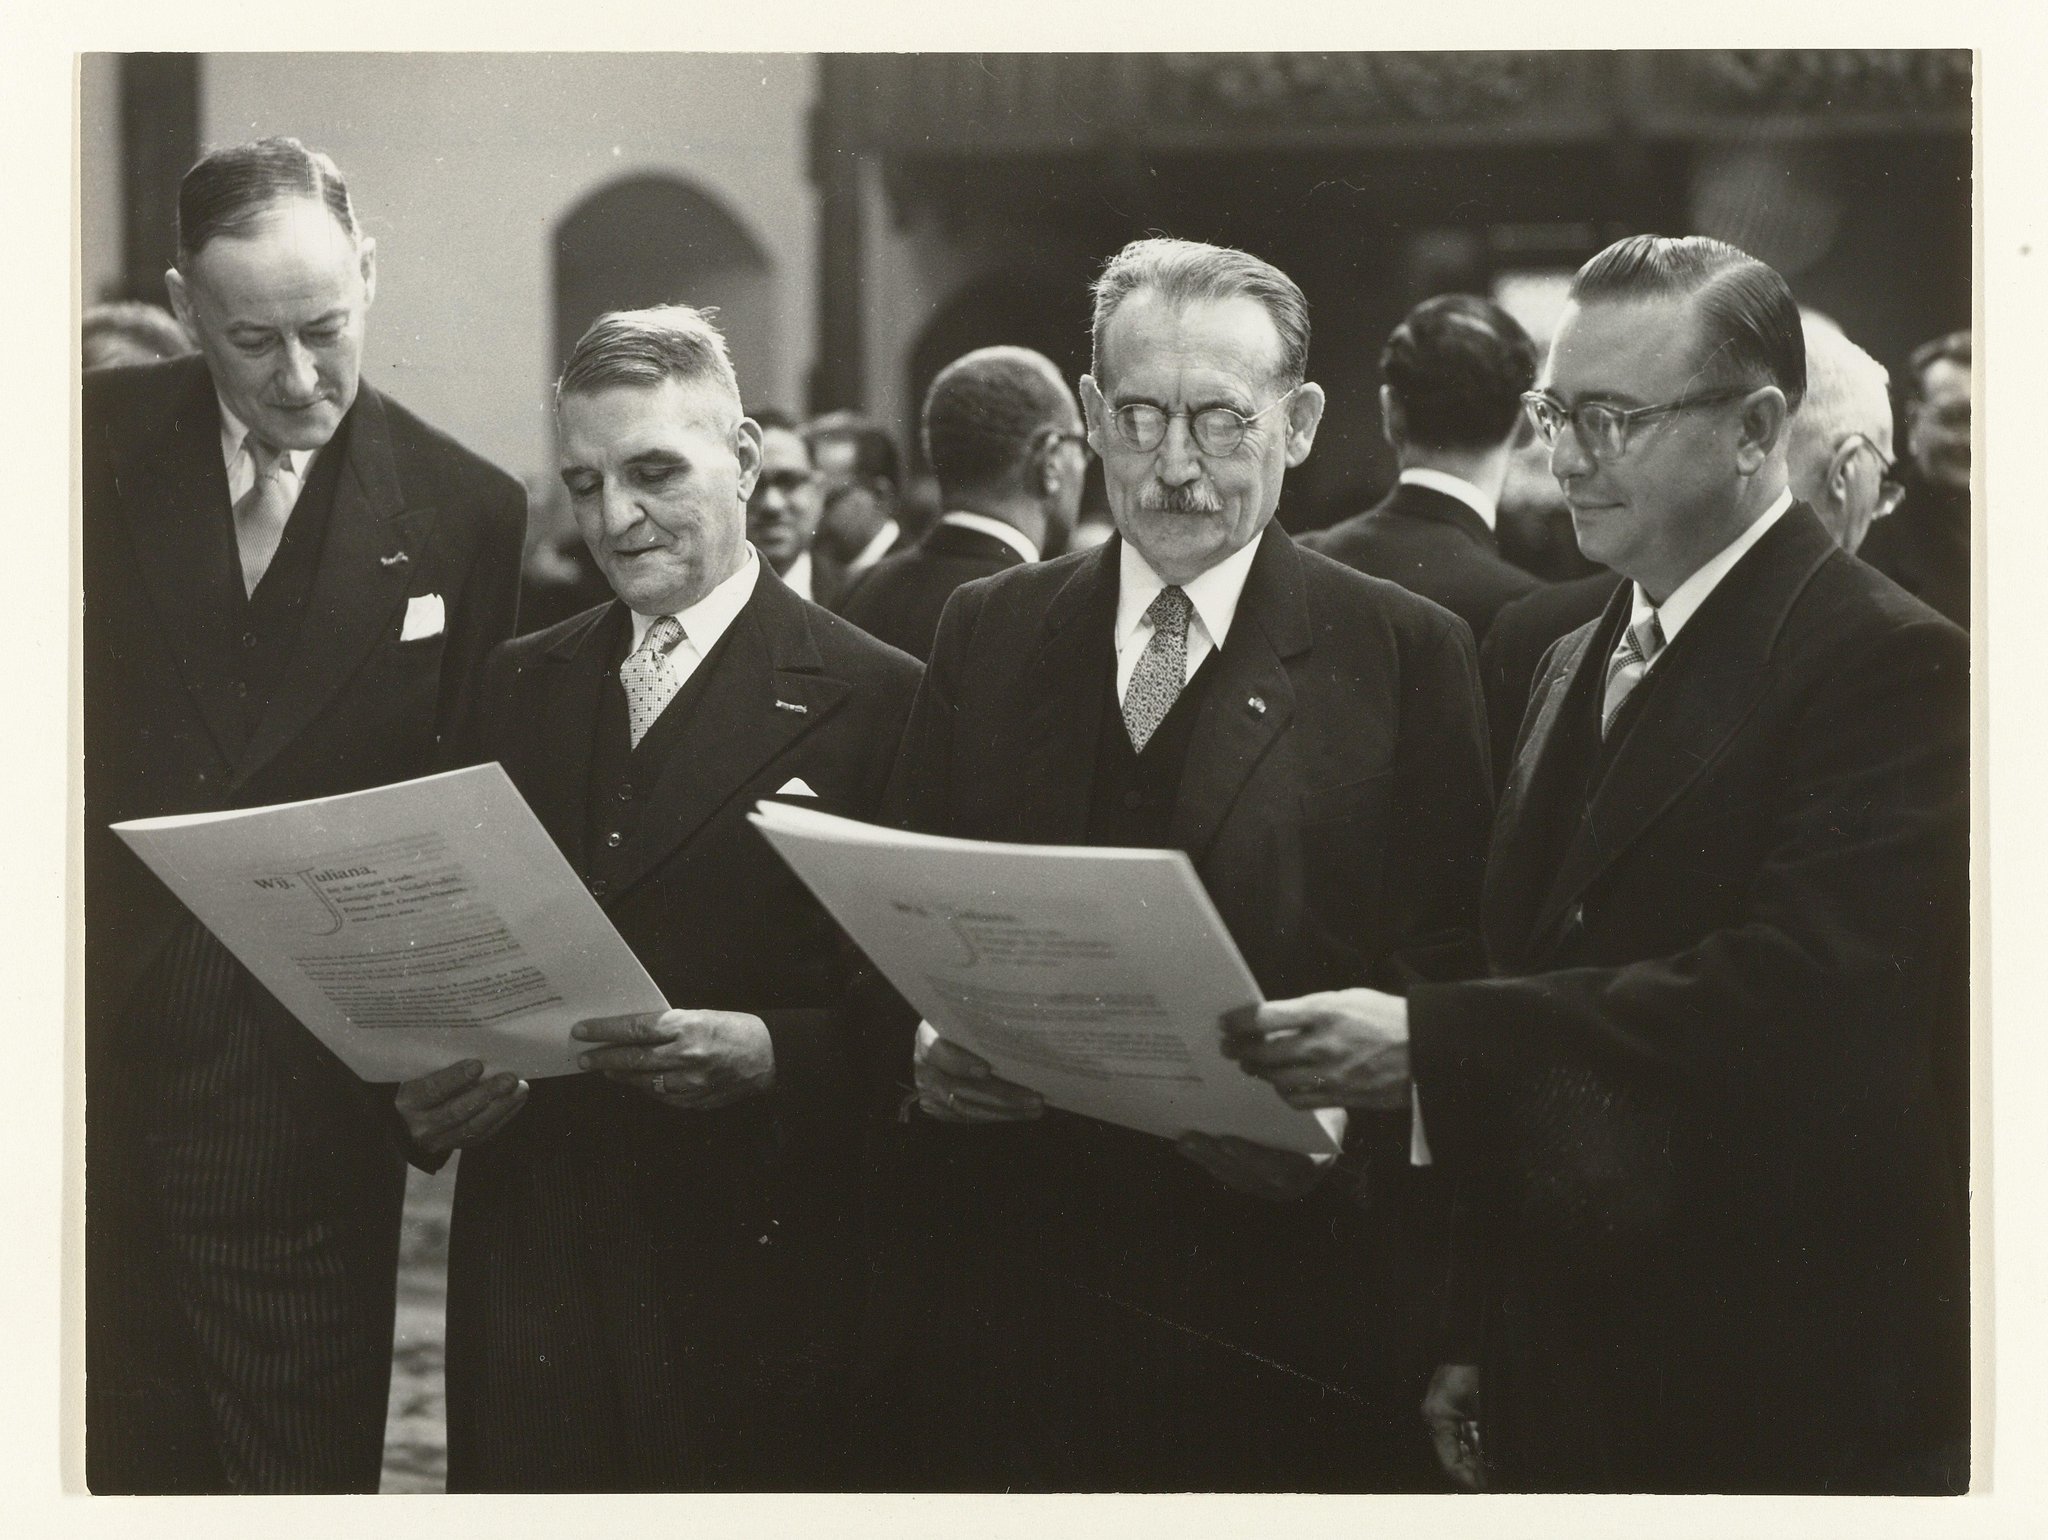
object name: photograph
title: Willem Drees en het Statuut met de West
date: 1954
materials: photographic support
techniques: photography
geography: the hague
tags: utrecht, willem drees, netherlands, suriname, the hague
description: Willem Drees bekijkt in de Ridderzaal het nieuwe Statuut voor het Koninkrijk der Nederlanden, 15 december 1954. Het Statuut regelde de nieuwe verhoudingen tussen Nederland, Suriname en de Nederlandse Antillen. Links van Drees staan de heren Kernkamp en Currie (Suriname), rechts van hem de heer Jonckheer (Nederlandse Antillen).